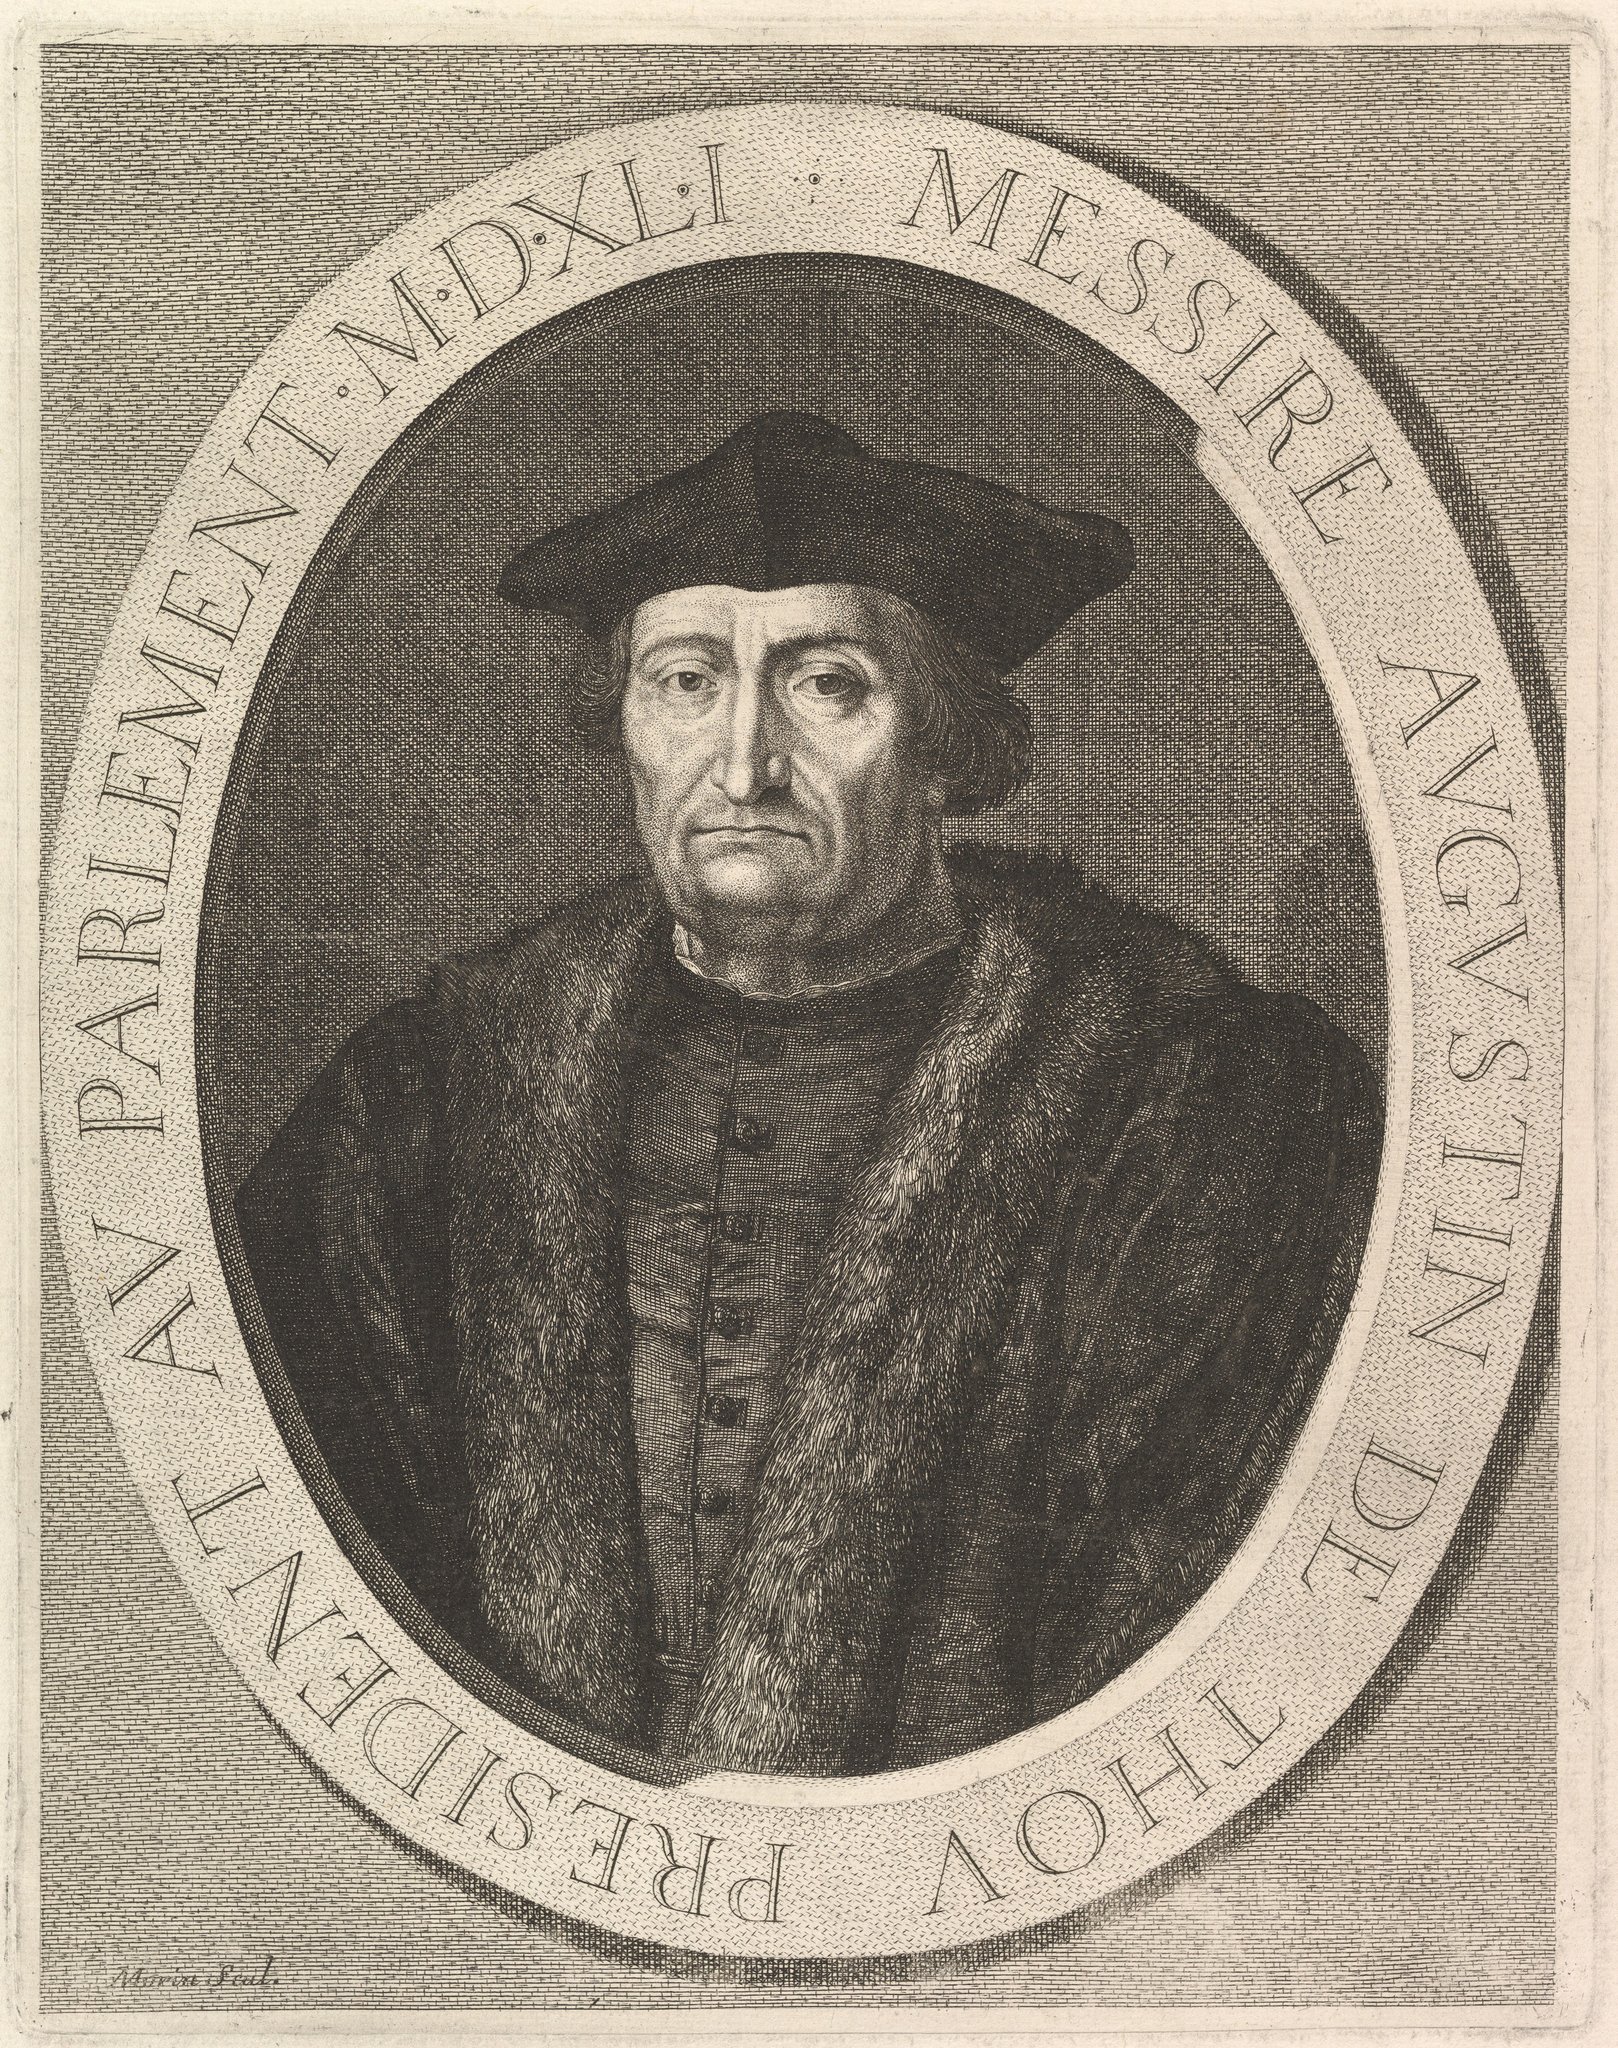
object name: print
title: Augustin de Thou, president au Parlement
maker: jean morin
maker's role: artist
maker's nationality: french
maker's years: 1605-1650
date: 1605-1650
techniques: etching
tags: men,portraits